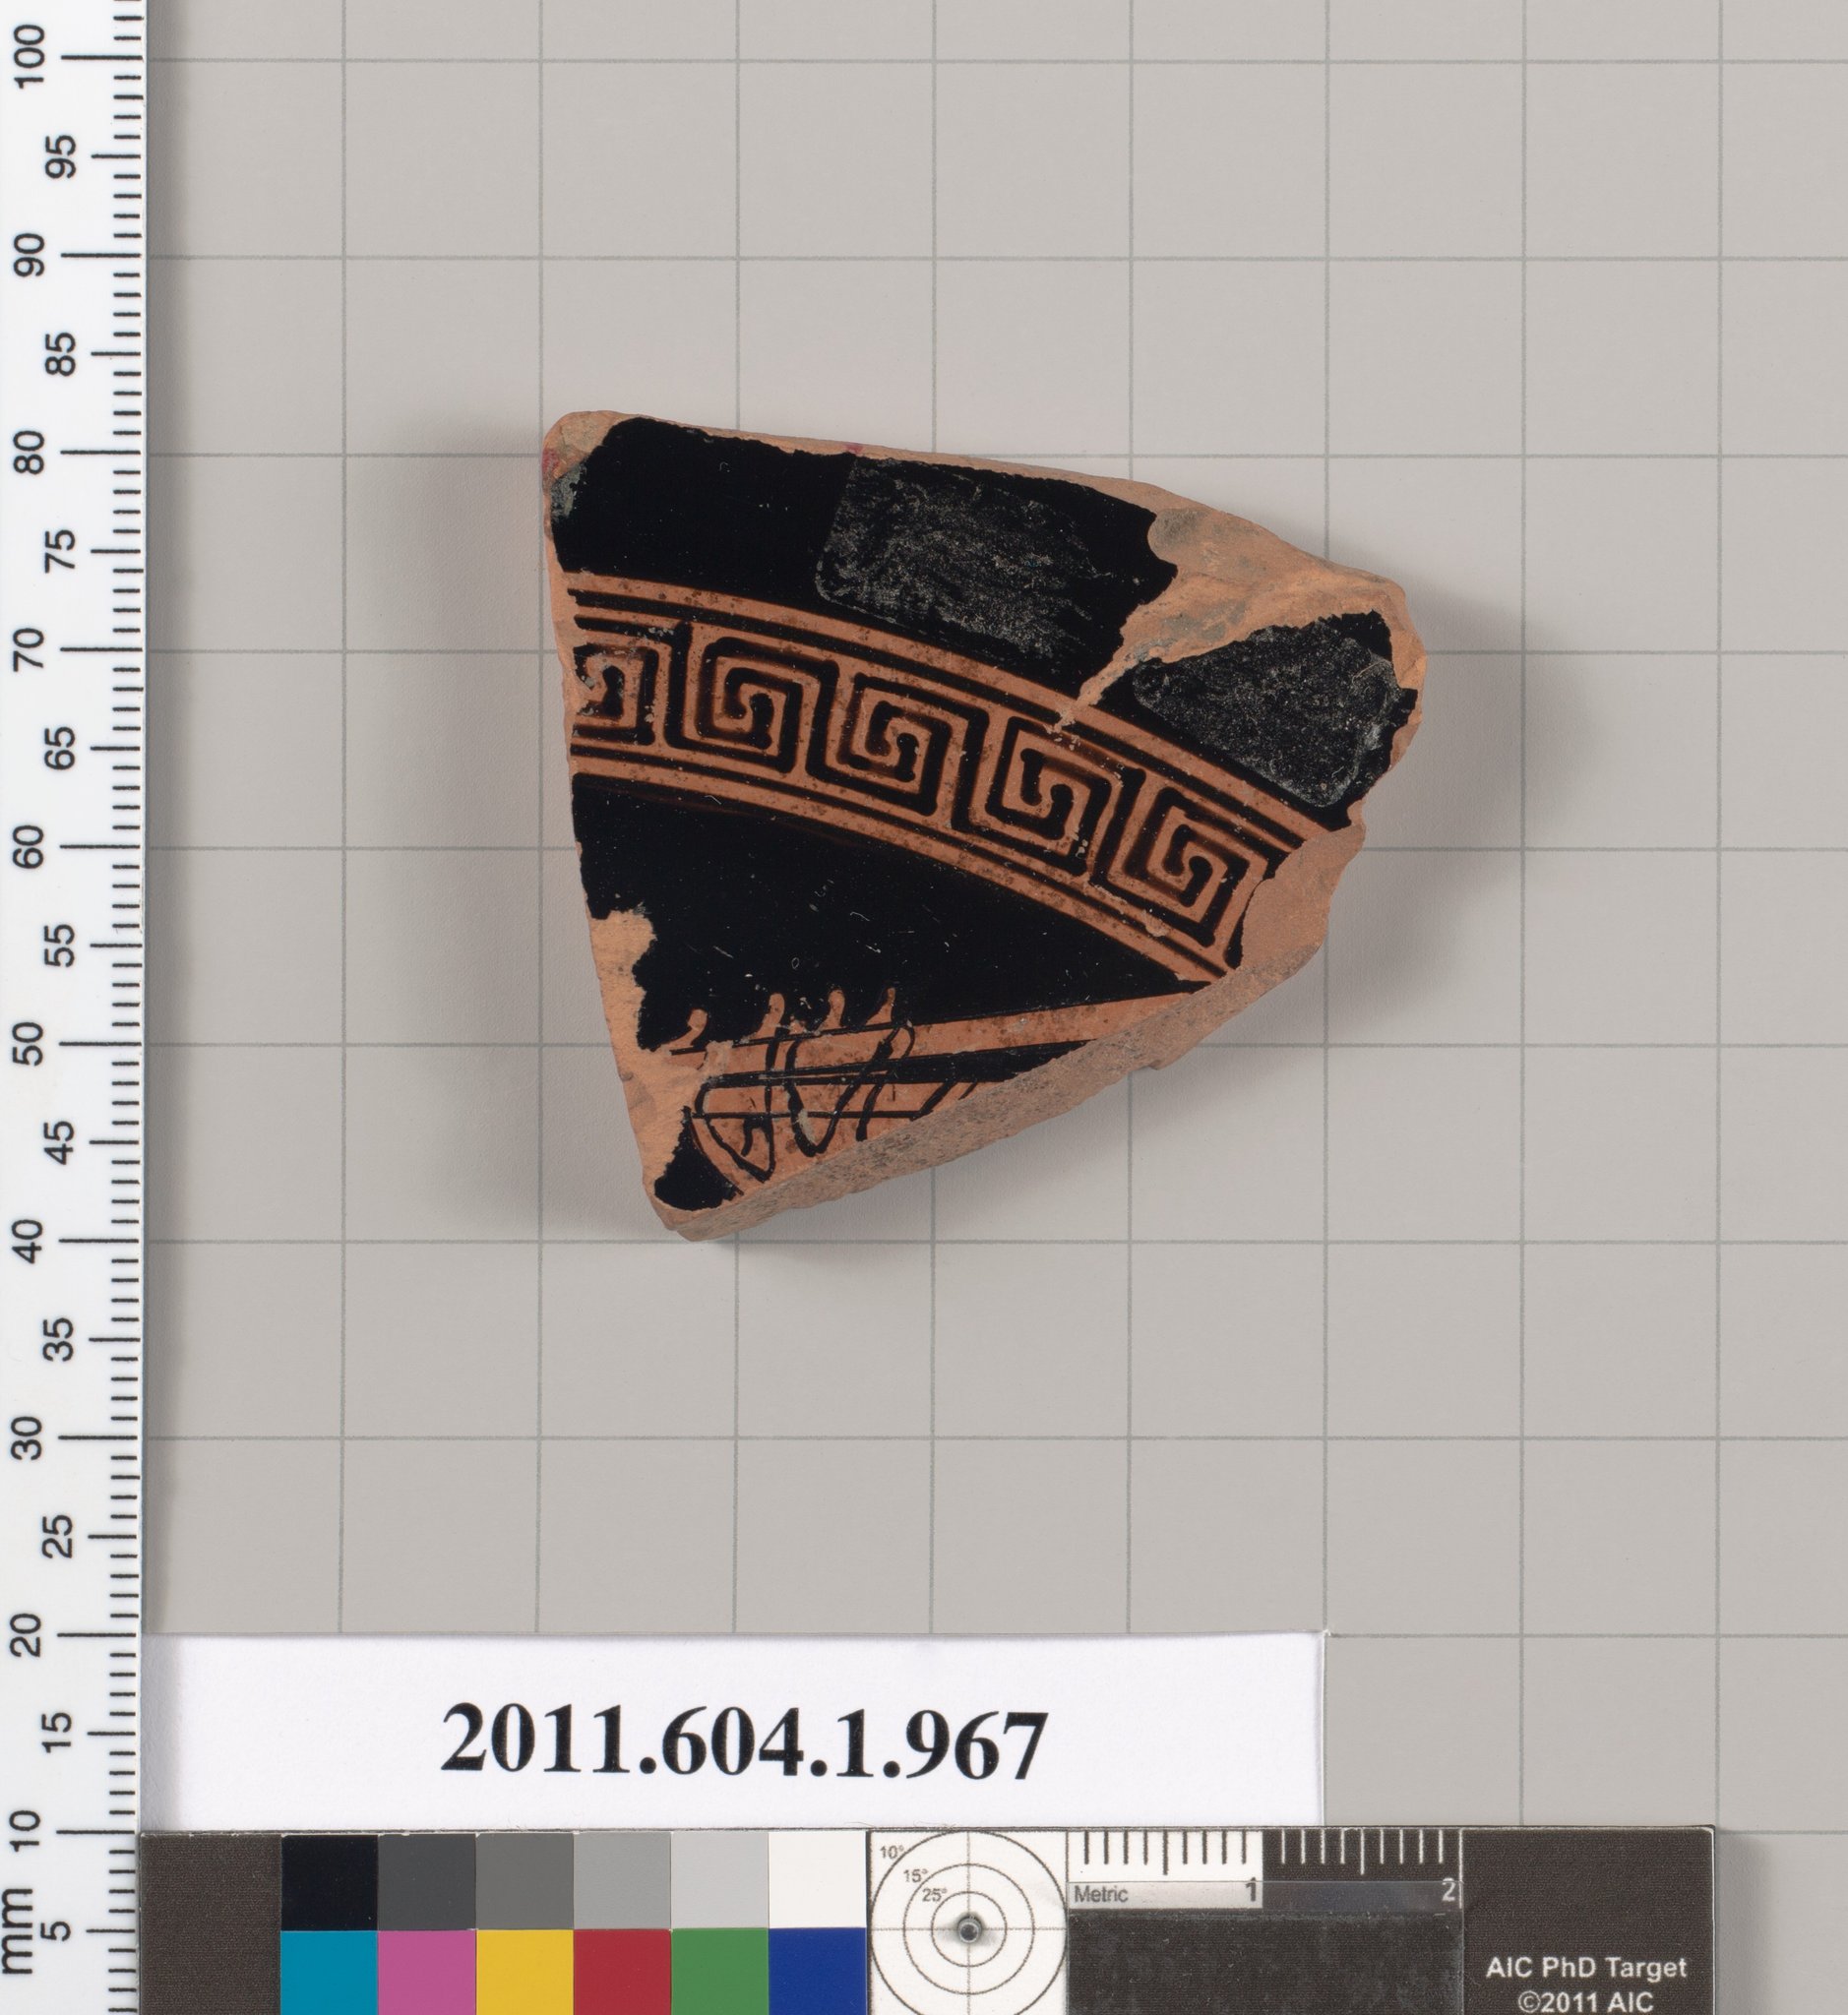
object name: kylix fragment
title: Terracotta fragment of a kylix (drinking cup)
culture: greek, attic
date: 490-480 BCE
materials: terracotta